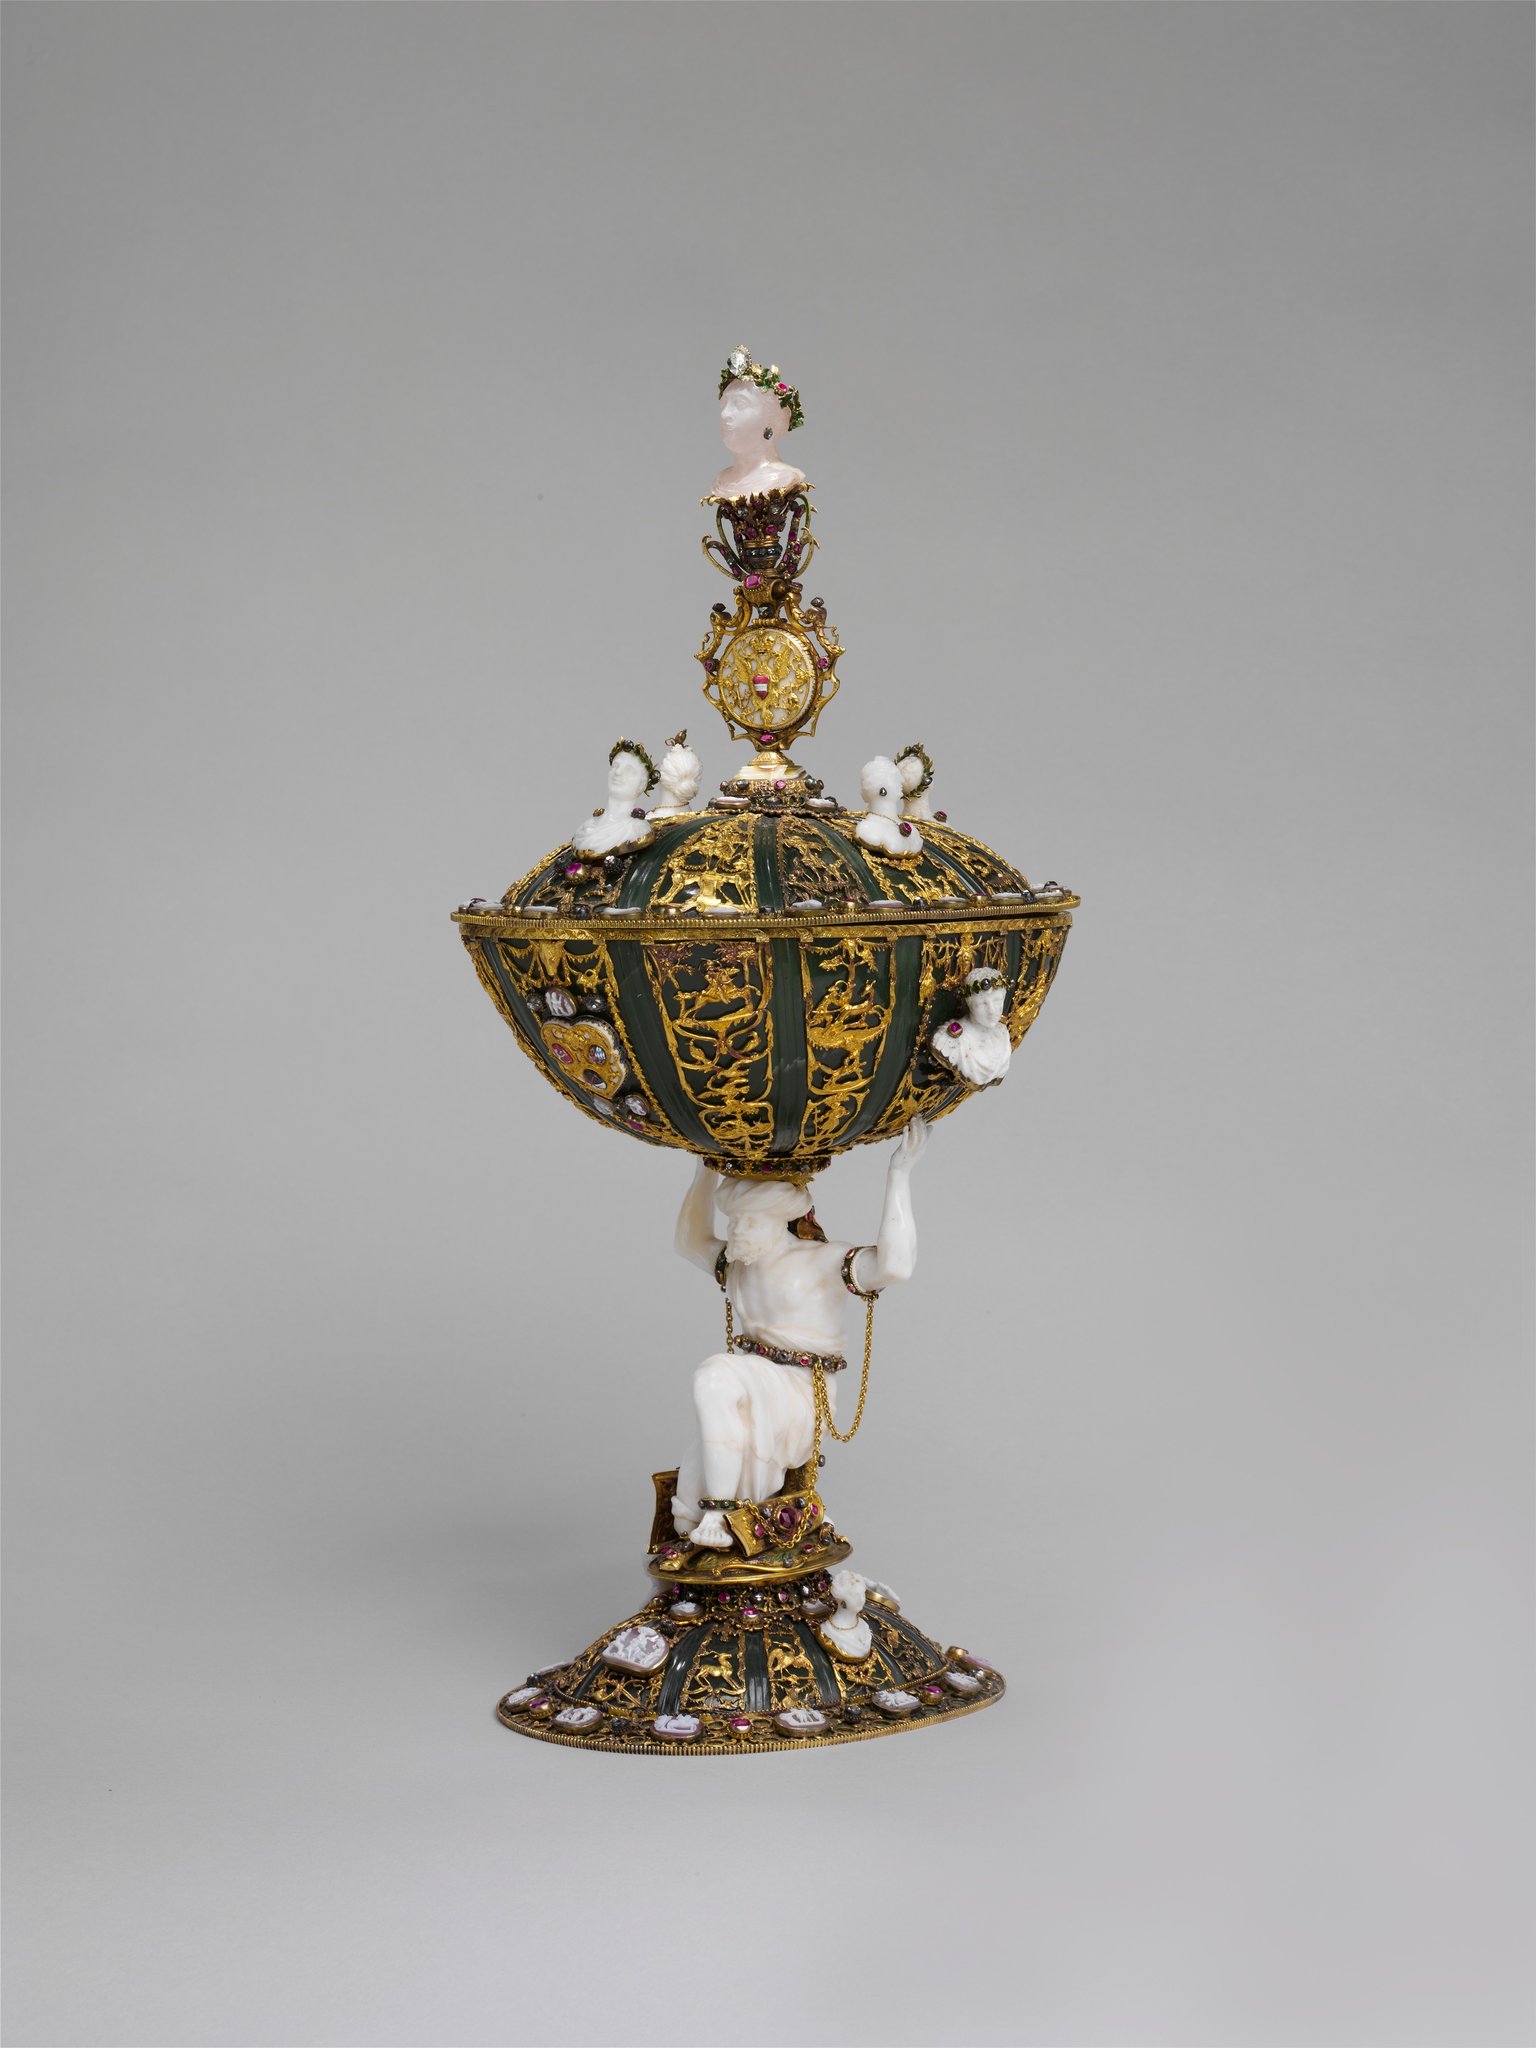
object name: cup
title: Standing Cup and Cover Supported by an Enchained Turk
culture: german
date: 1705-1711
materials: stone, diamond, enamel, garnet, gold, jade, paint, gemstone, silver gilt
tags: animals,men,hunting,coat of arms